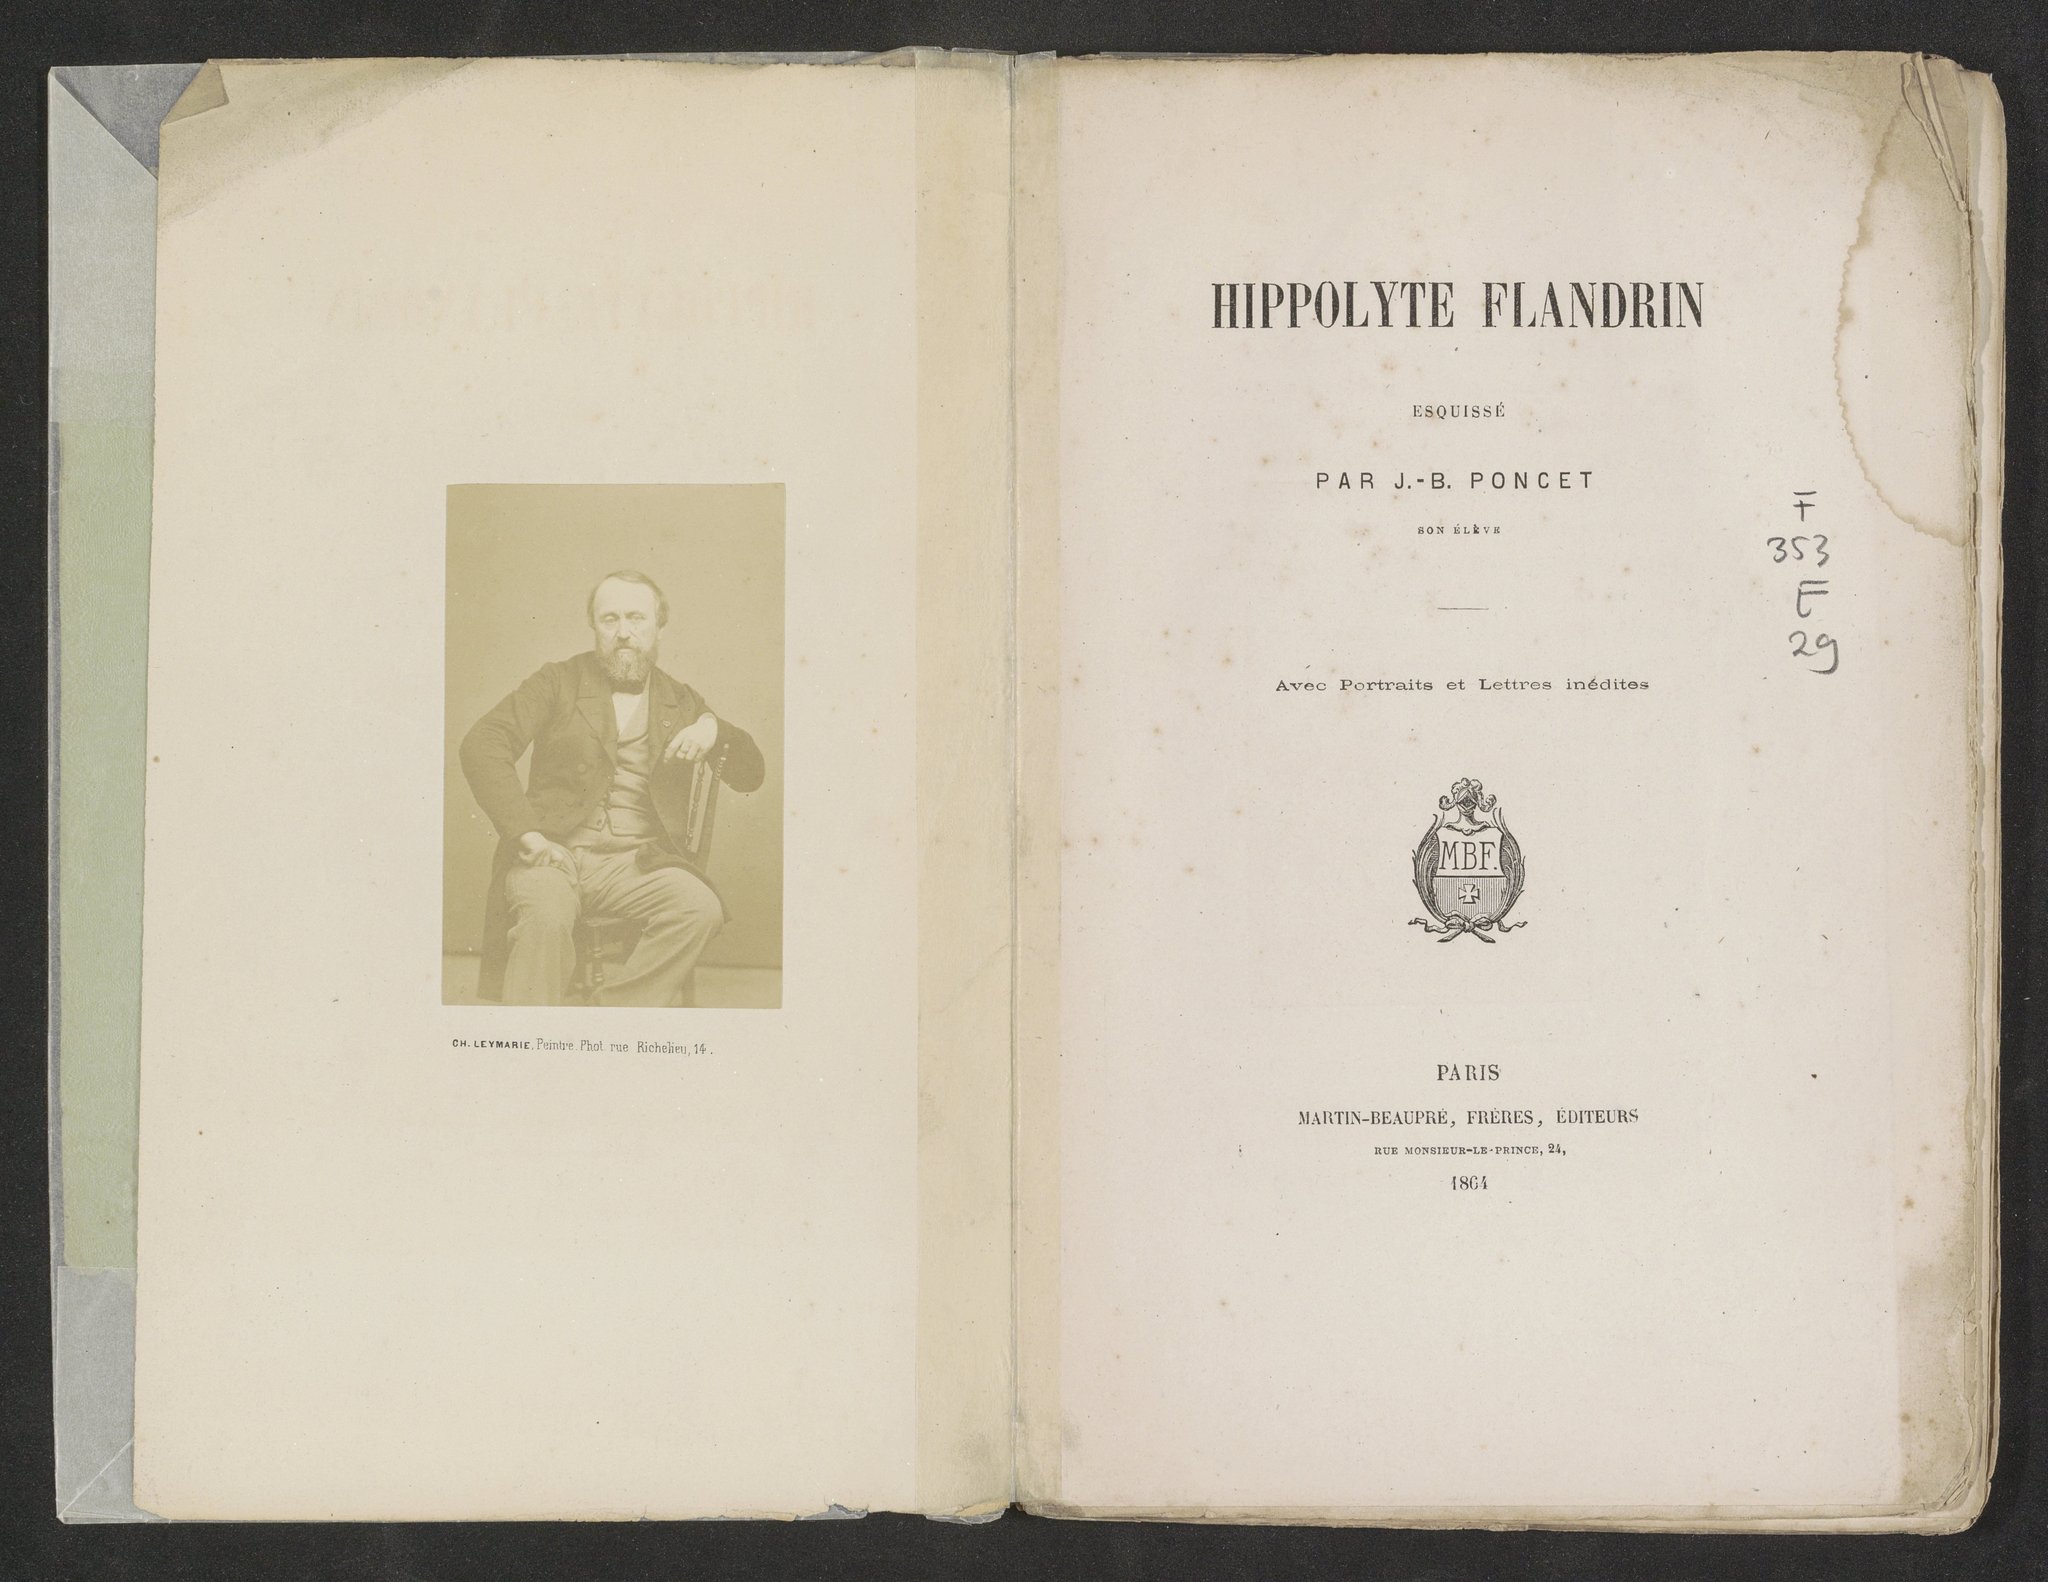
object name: photograph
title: Portret van vermoedelijk Hippolyte Flandrin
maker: charles leymarie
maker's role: fotograaf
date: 1854-1864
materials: photographic support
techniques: albumen print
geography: paris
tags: portrait, self-portrait of painter